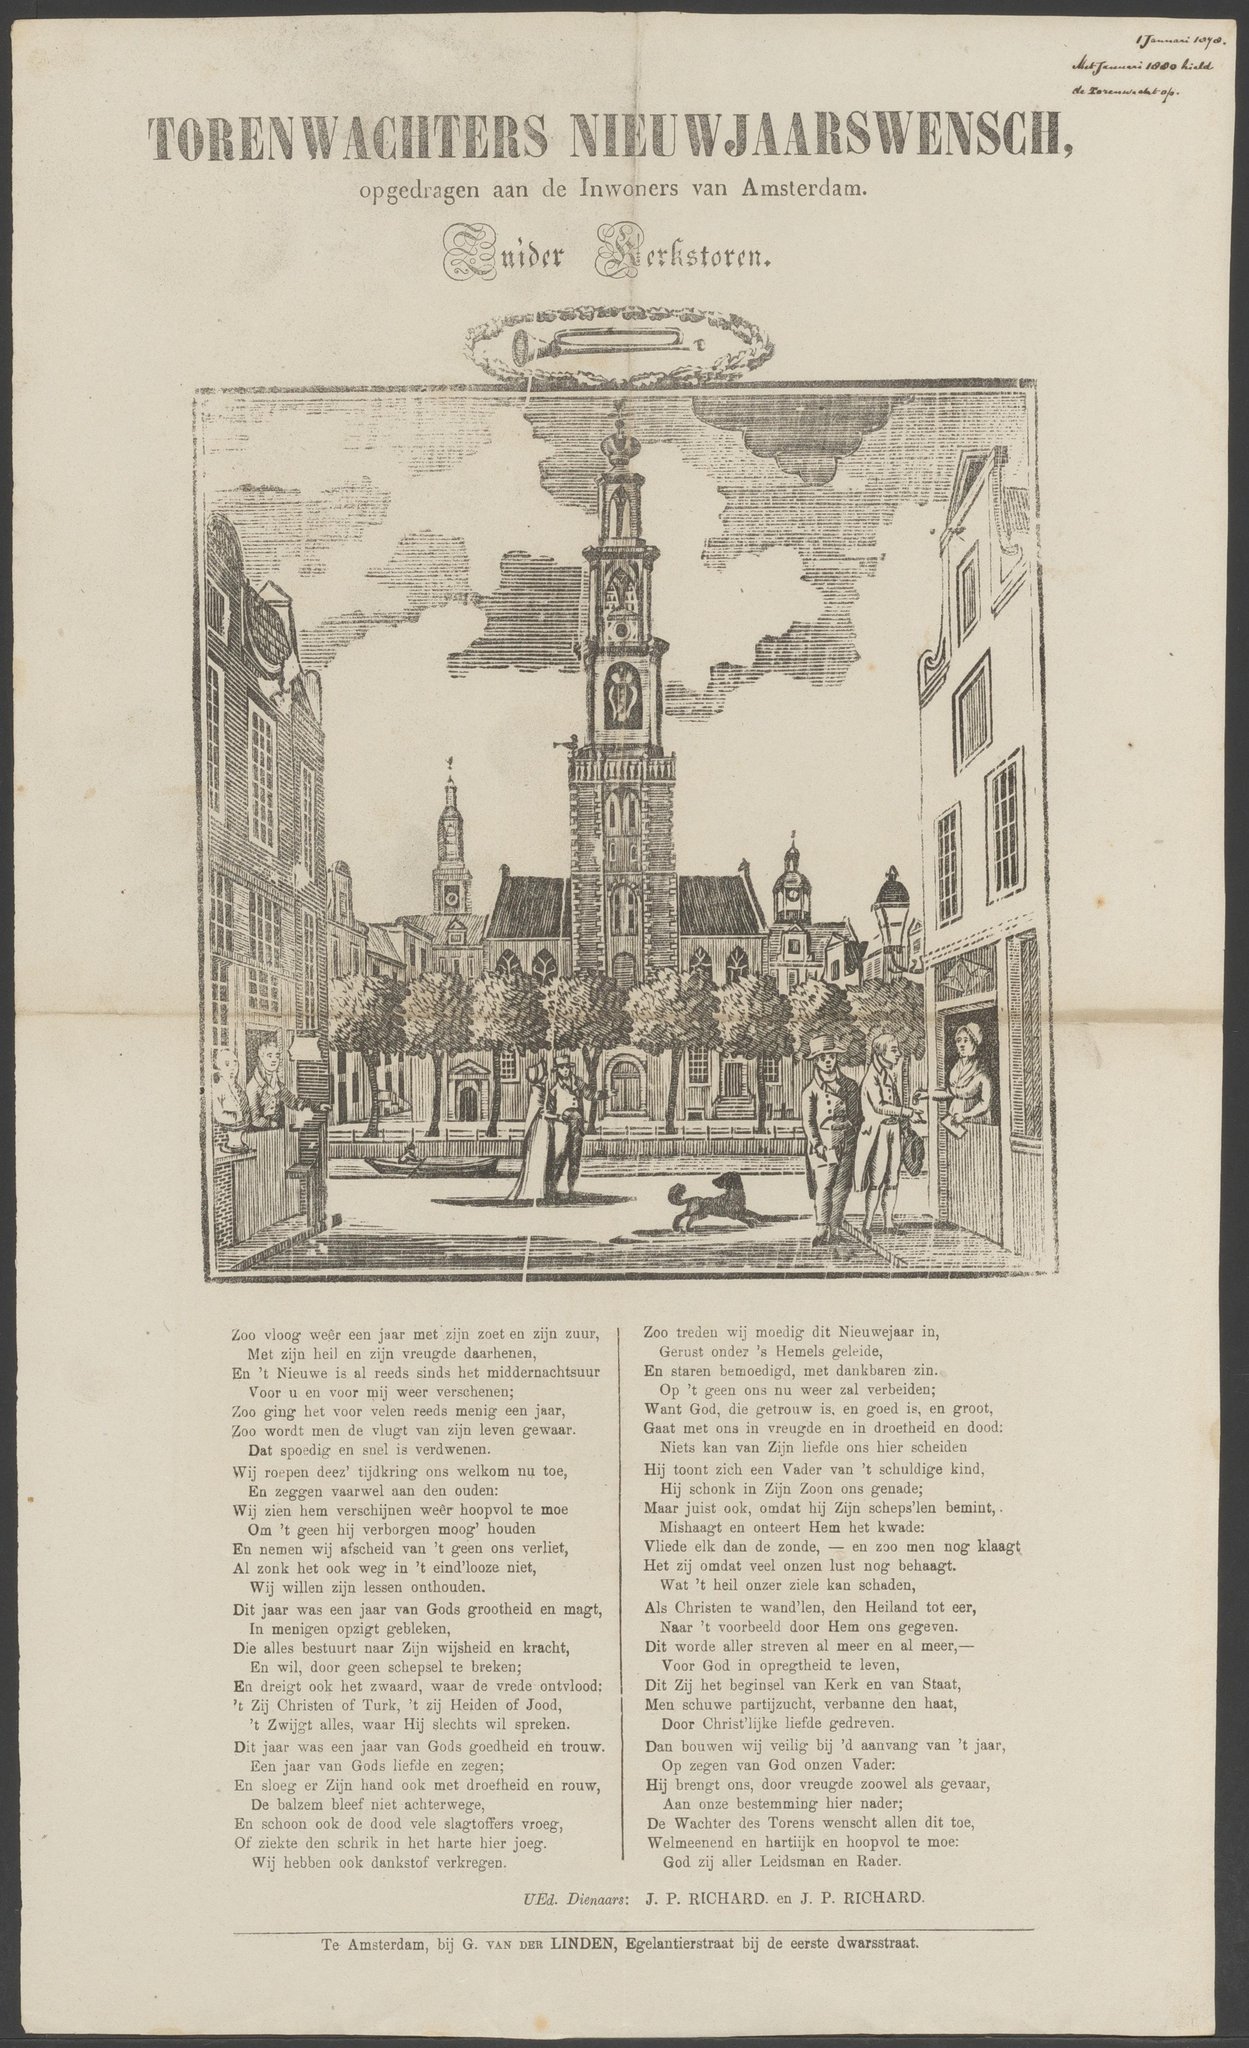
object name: print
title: Torenwachters Nieuwjaarswensch, opgedragen aan de Inwoners van Amsterdam, Zuider Kerkstoren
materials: paper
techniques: letterpress printing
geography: amsterdam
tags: parts of church exterior and annexes: tower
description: Nieuwjaarswens van de torenwachters van de Zuiderkerkstoren te Amsterdam. Bovenaan een gezicht op een kerktoren. Daaronder centraal een gedicht in twee kolommen. Aangeboden door de torenwachters: J.P. Richard en J.P. Richard. Onderwerpsrubrieken binnen de Atlas Zeden en Gewoonten: Zeden en gewoonten in engeren zin, Volksleven, Volksbladen, Nieuwjaars- en Kerstwenschen, Amsterdam.